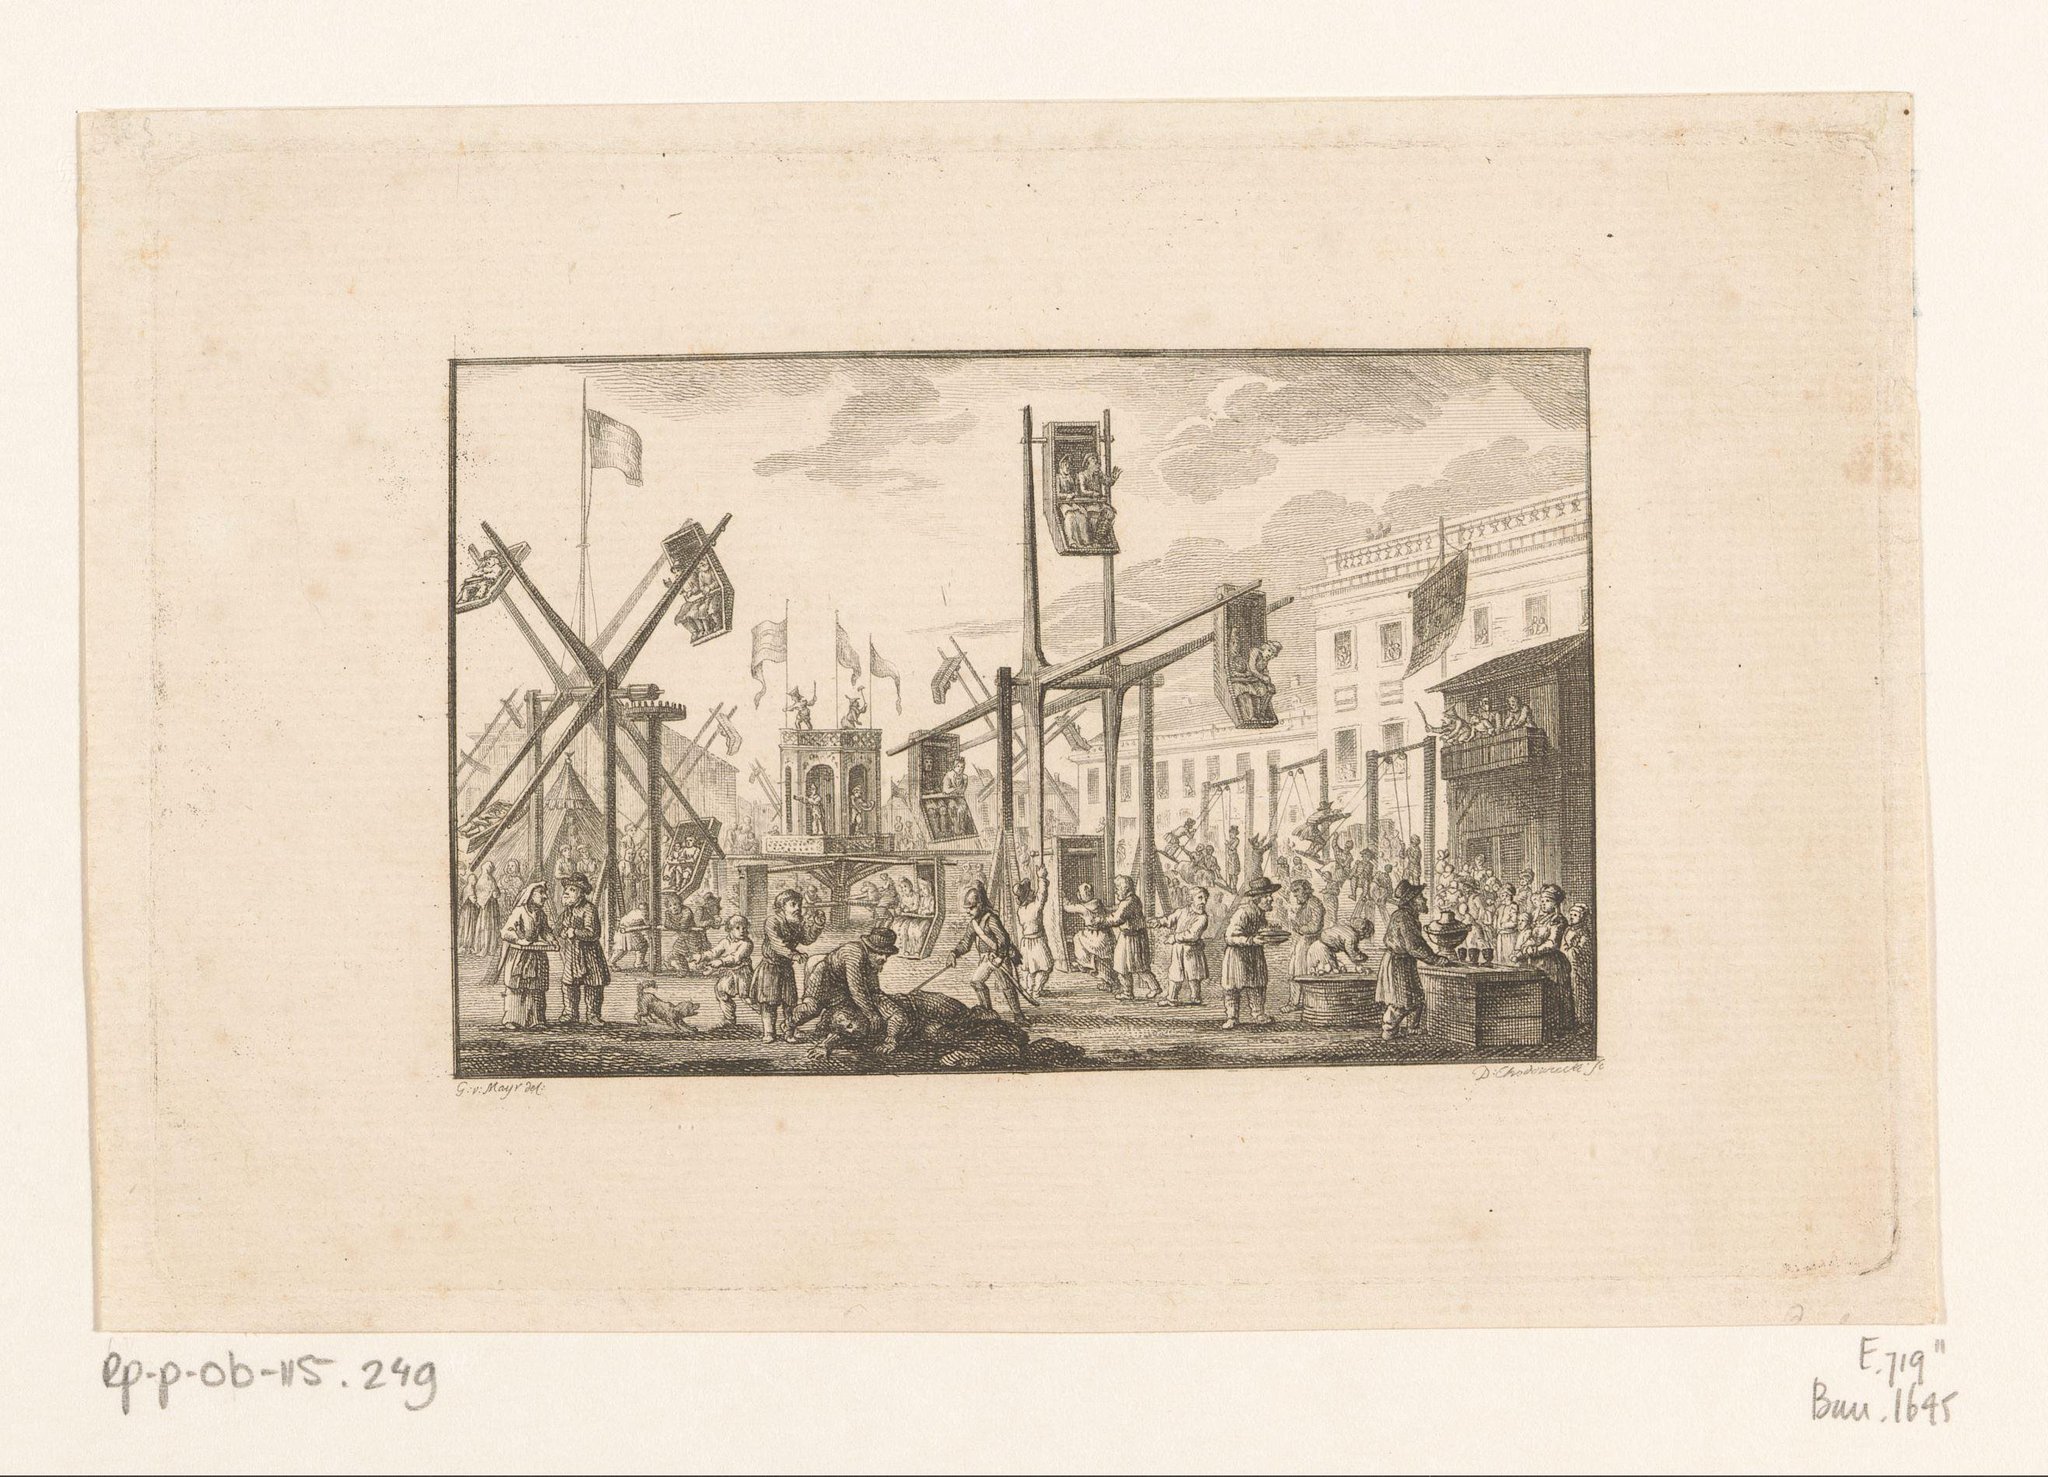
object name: print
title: Kermis in St. Petersburg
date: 1793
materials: paper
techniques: etching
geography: berlin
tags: literature, giant wheel, ferris wheel, drunkard, pleasure fair and circus, swing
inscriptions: collector's mark: Lugt 2228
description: Prent gebruikt voor: Storch, Heinrich. Gemählde von St. Petersburg. 2 dln. Riga: Johann Friedrich Hartknoch, 1794, dl. 2.